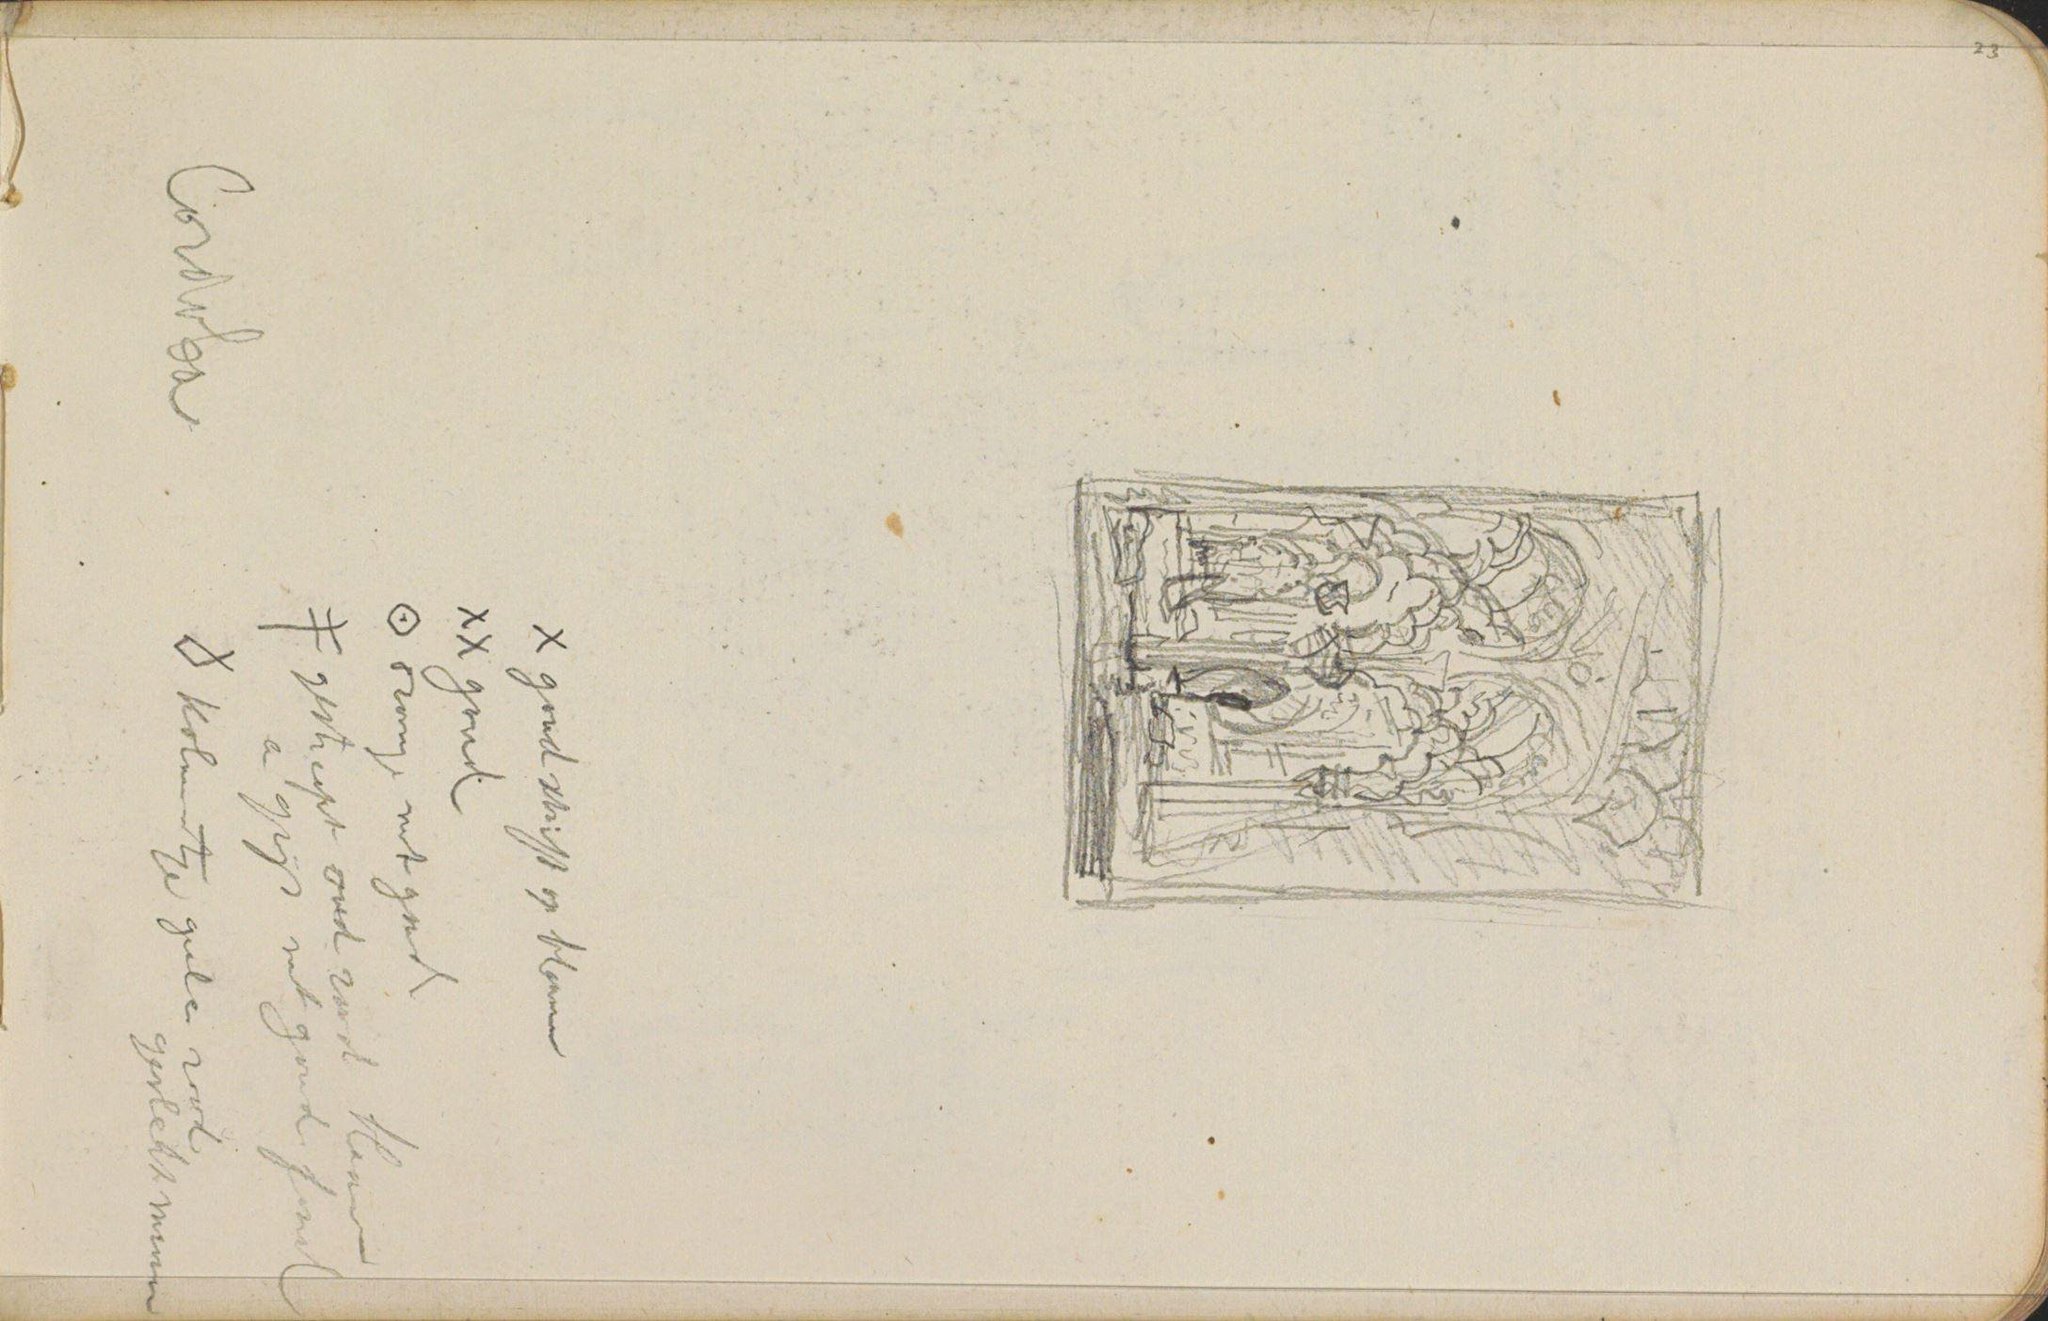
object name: sketchbook leaf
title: Interieur van de Mezquita kathedraal van Córdoba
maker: marius bauer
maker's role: draughtsman, print maker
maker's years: 1867-1932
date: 1902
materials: paper, pencil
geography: córdoba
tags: interior of church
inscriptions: annotation: ‘Cordoba’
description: Pagina 23 uit een schetsboek met 30 bladen.